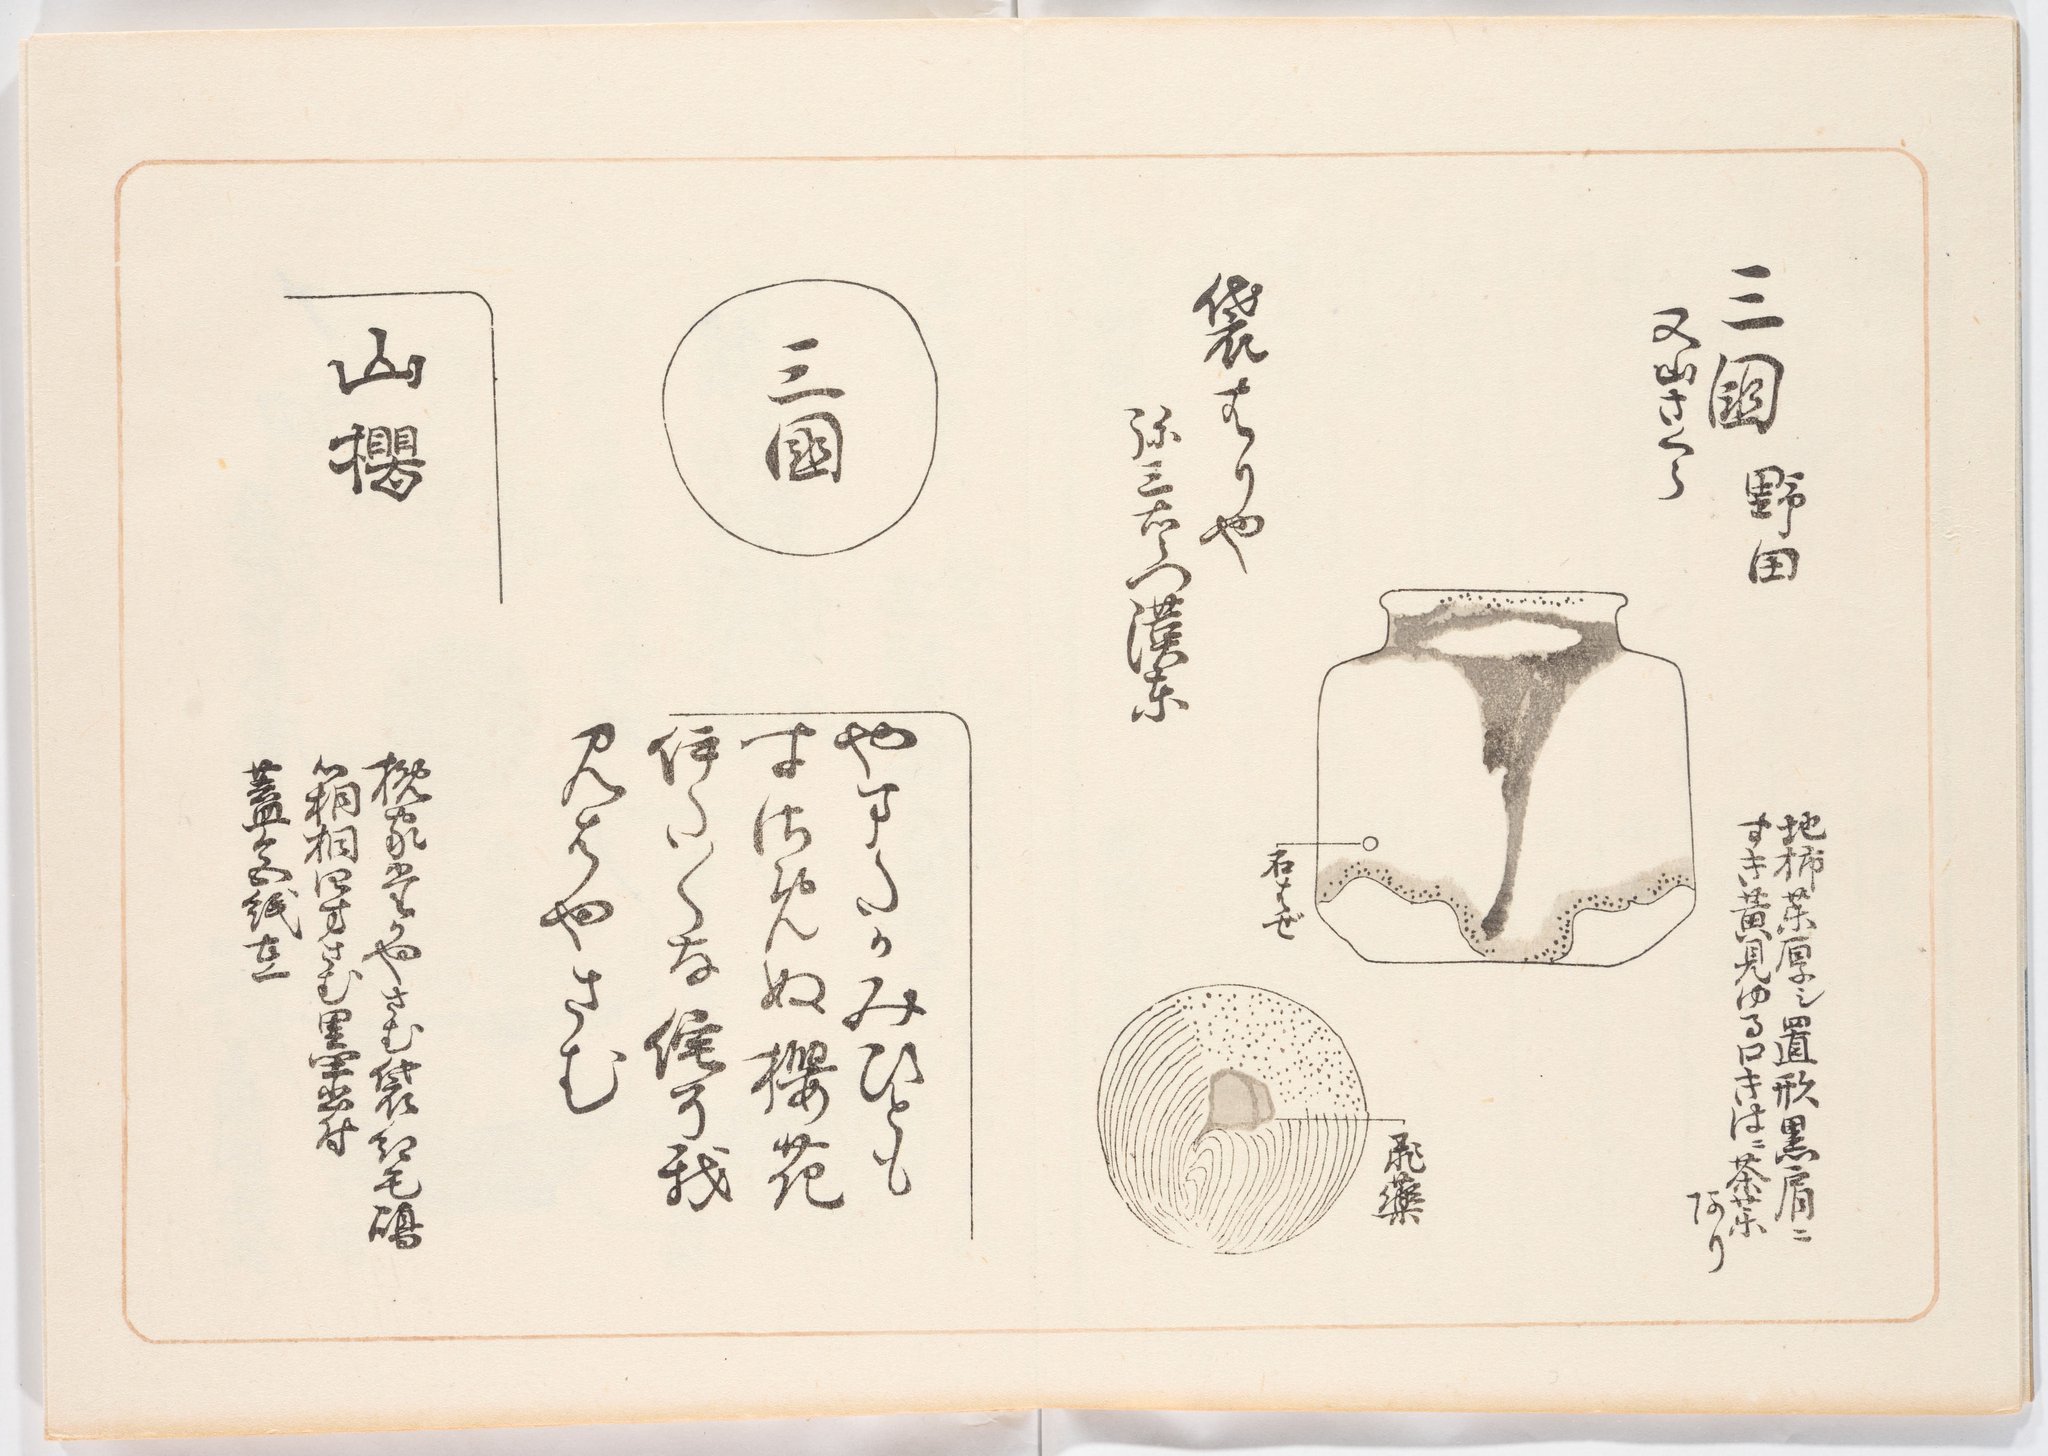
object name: illustrated book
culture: japanese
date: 1893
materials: ink, paper